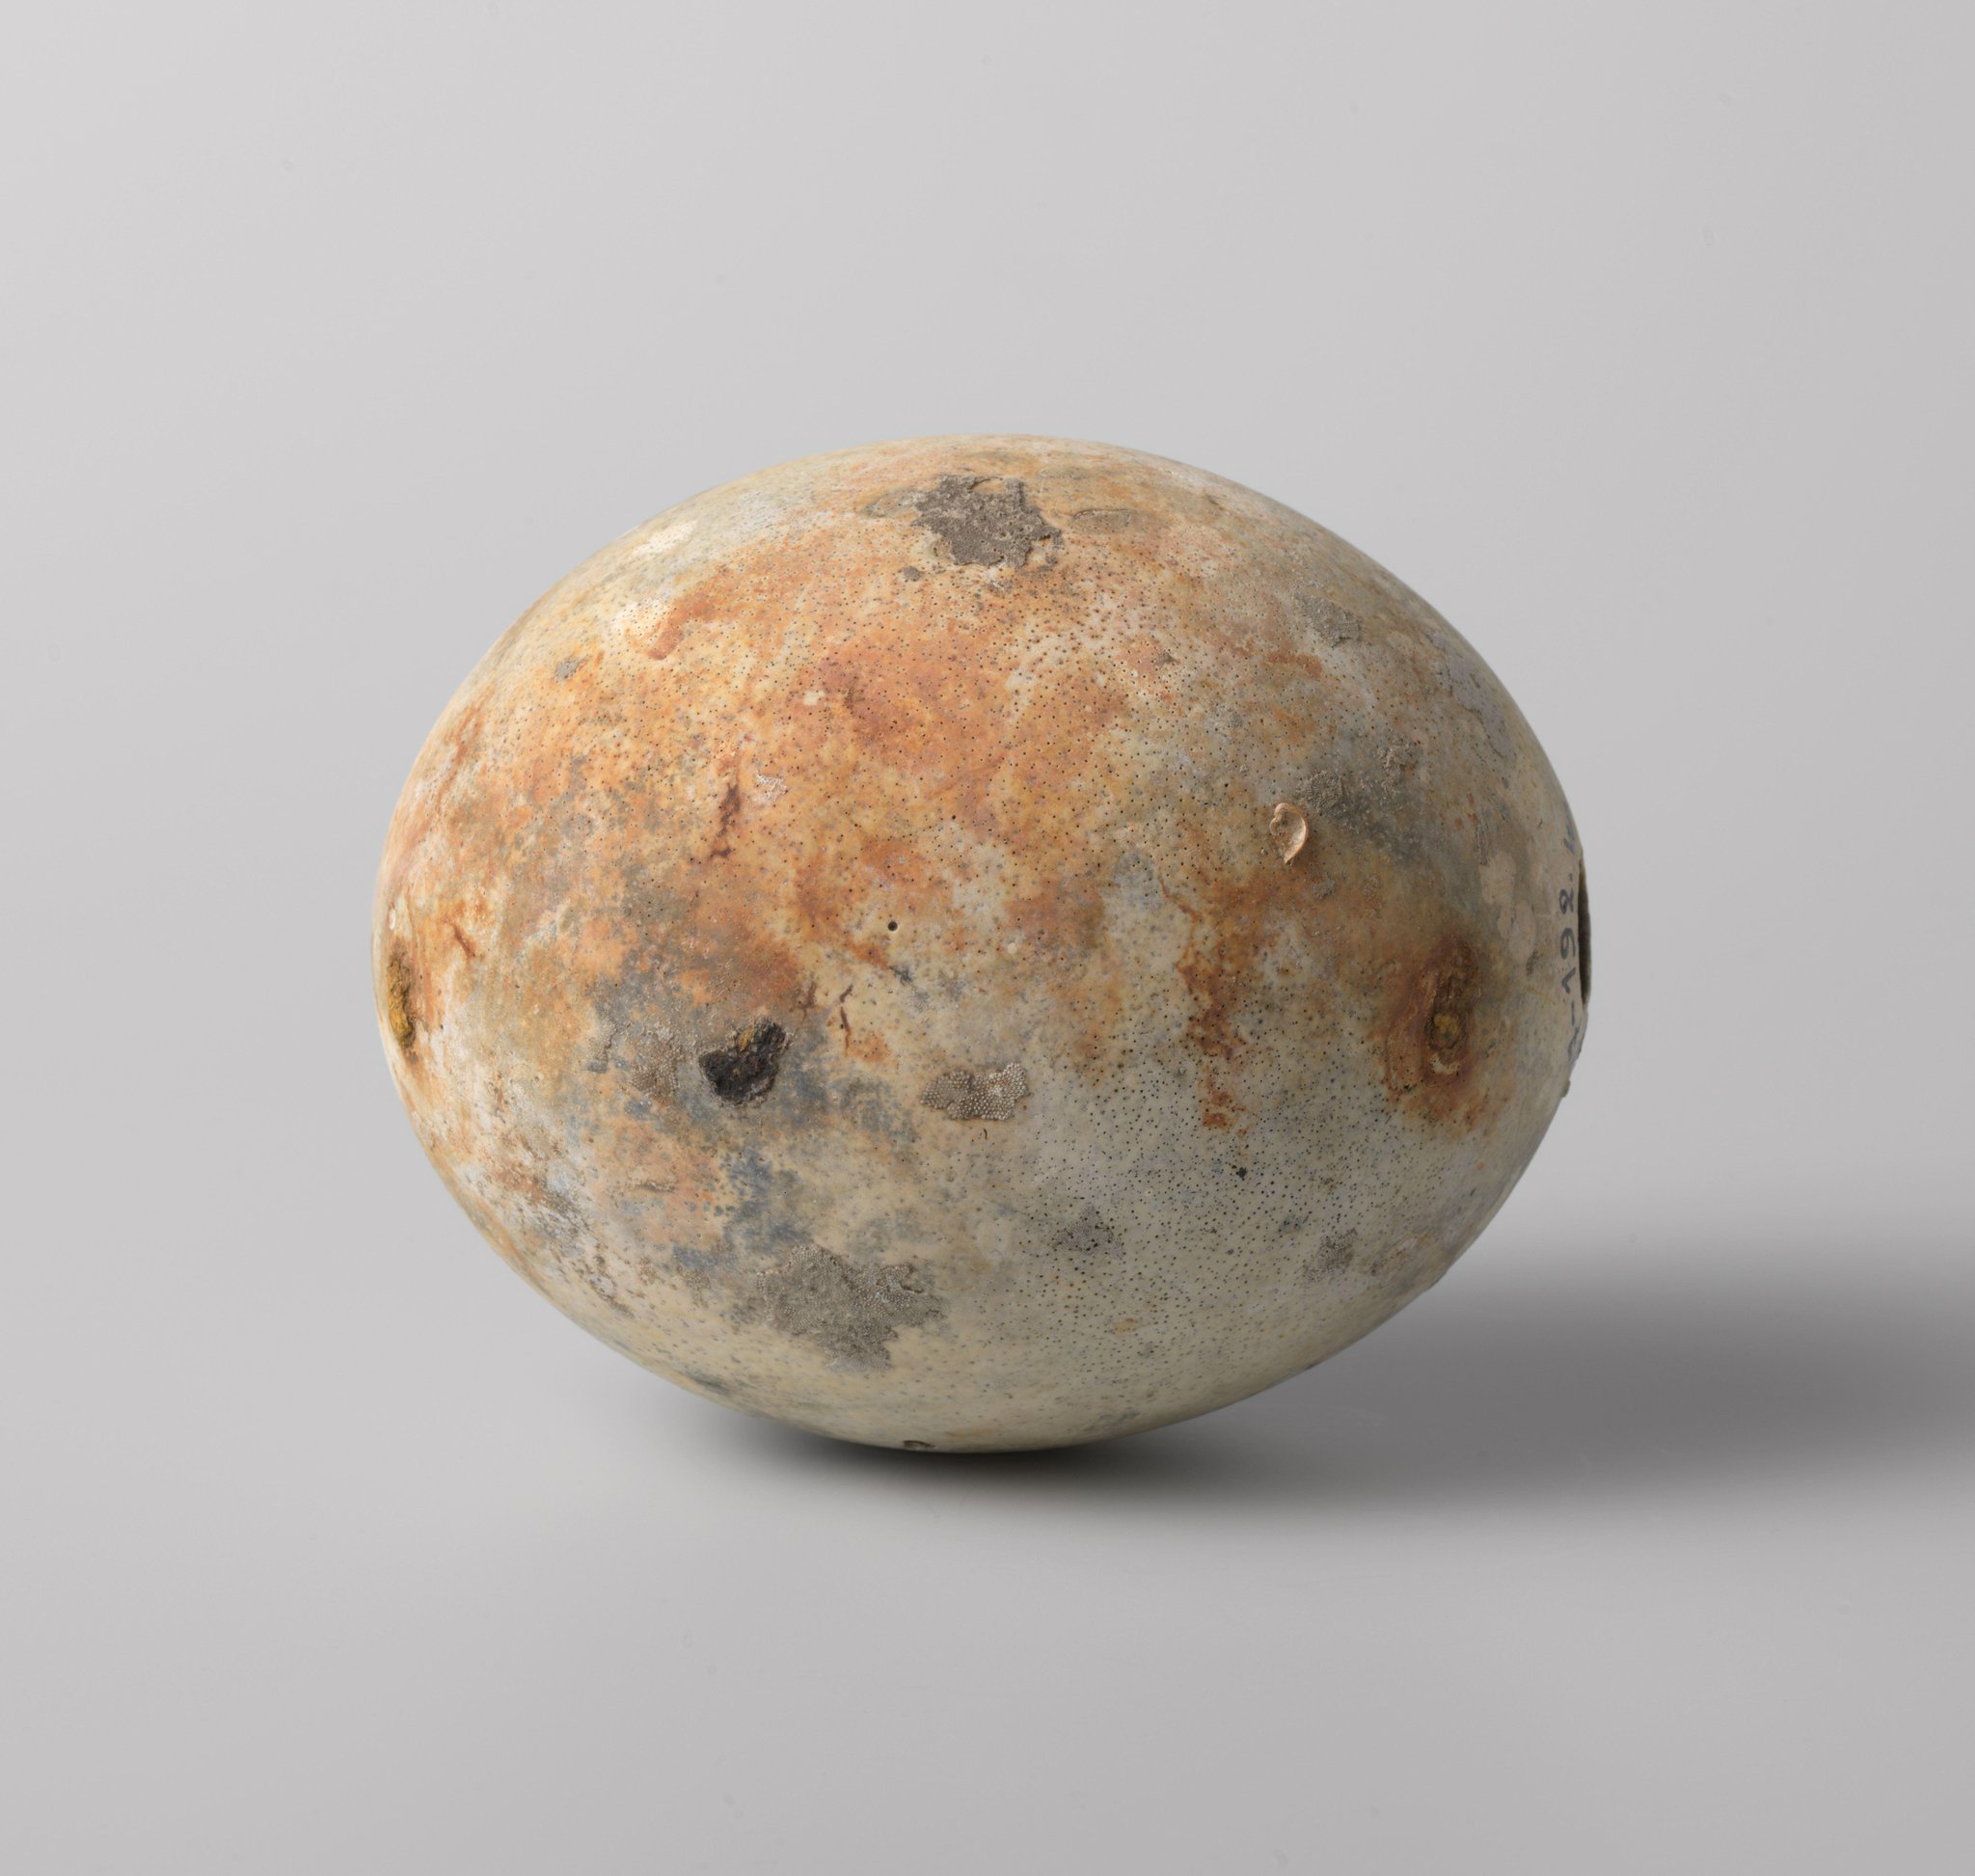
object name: egg biological body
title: Cassowary egg from the wreck of the Dutch East India ship Witte Leeuw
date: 1613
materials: egg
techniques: egg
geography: southeast asia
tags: verenigde oostindische compagnie, sint-helena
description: Ei van een casuaris uit V.O.C.-schip de 'Witte Leeuw'. Groot ei met een grijswitte schaal.